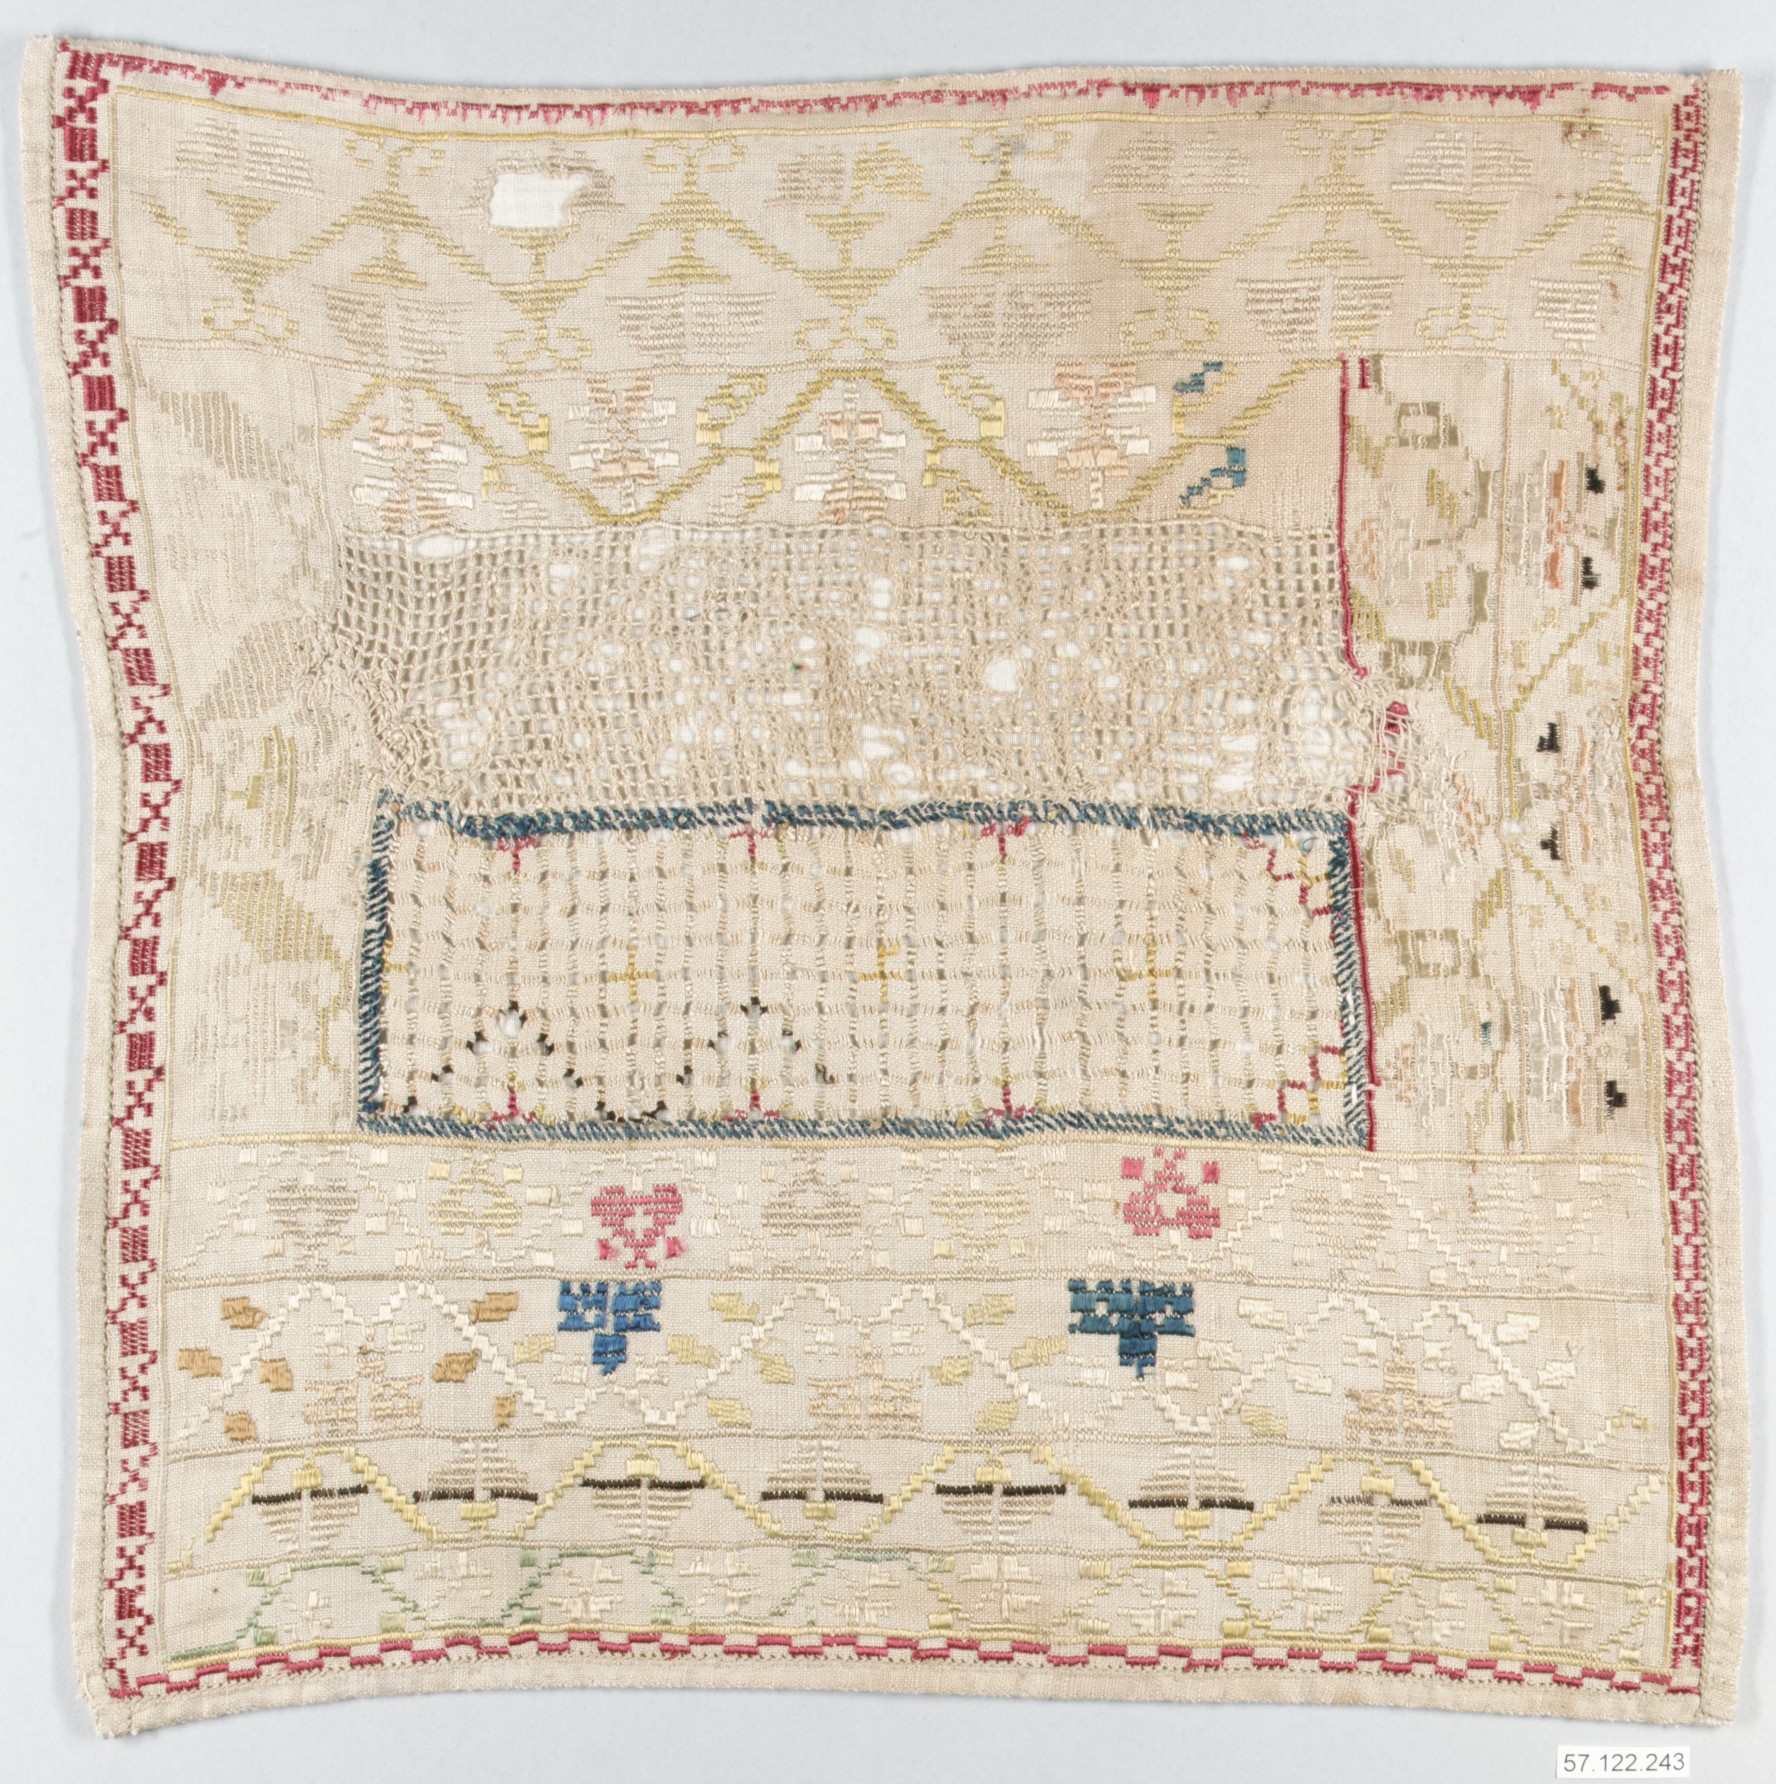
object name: sampler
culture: mexican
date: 1801-1900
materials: linen, silk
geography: mexico